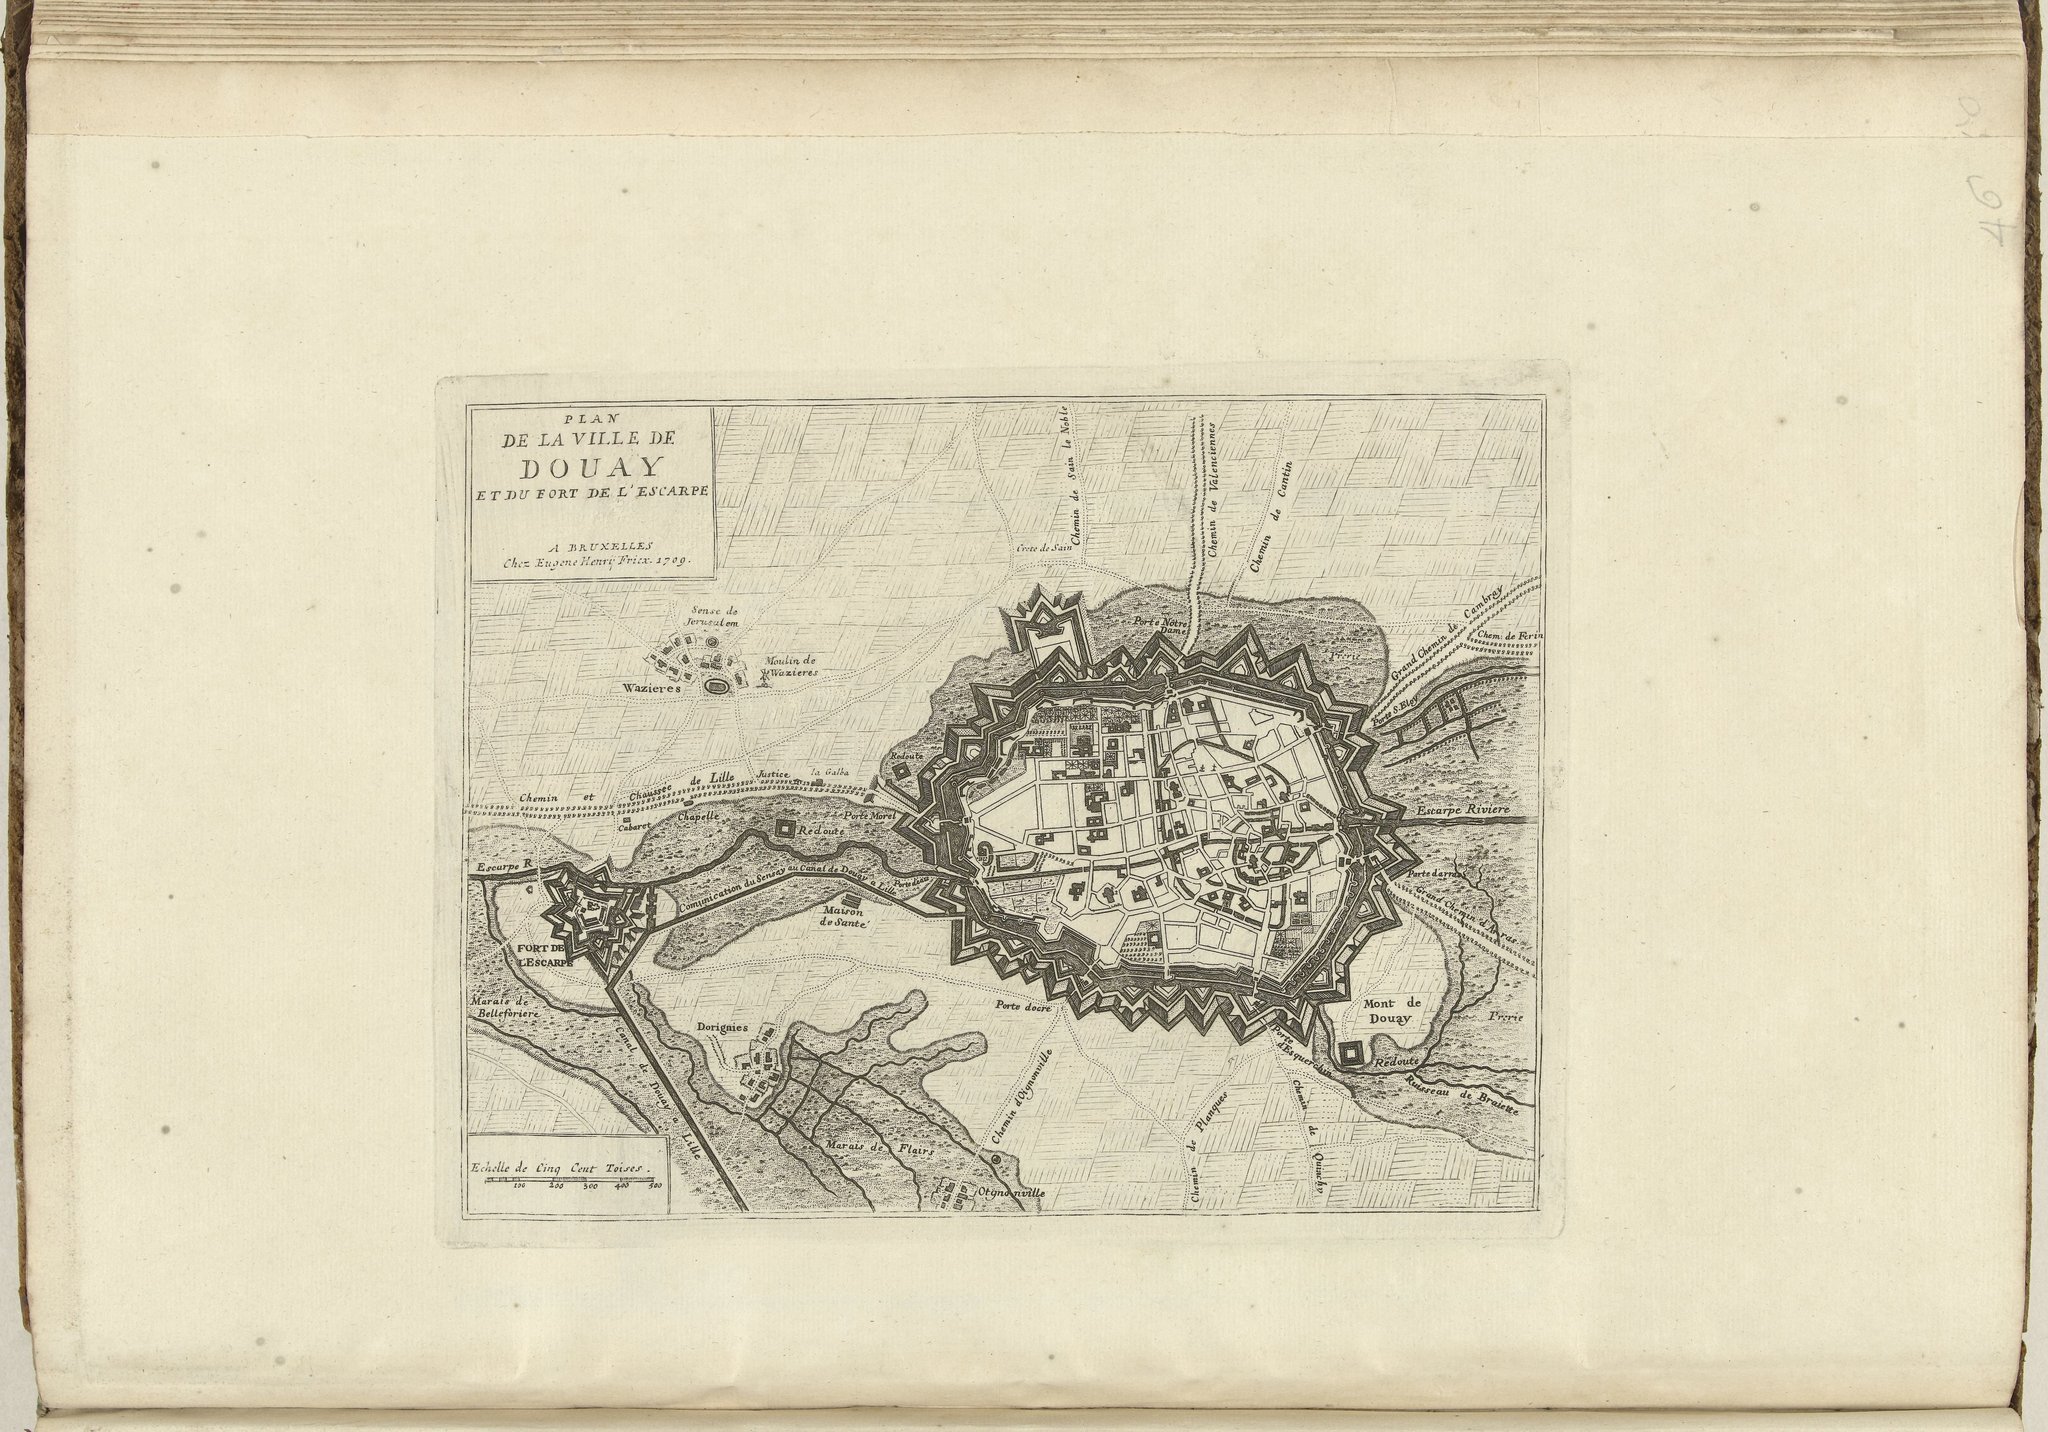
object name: print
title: Plattegrond van Douai, 1709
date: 1709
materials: paper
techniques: engraving, etching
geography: brussels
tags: maps of cities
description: Plattegrond van Douai, 1709. Onderdeel van een gebundelde verzameling van plannen van veldslagen en steden vermaard in de Spaanse Successieoorlog.